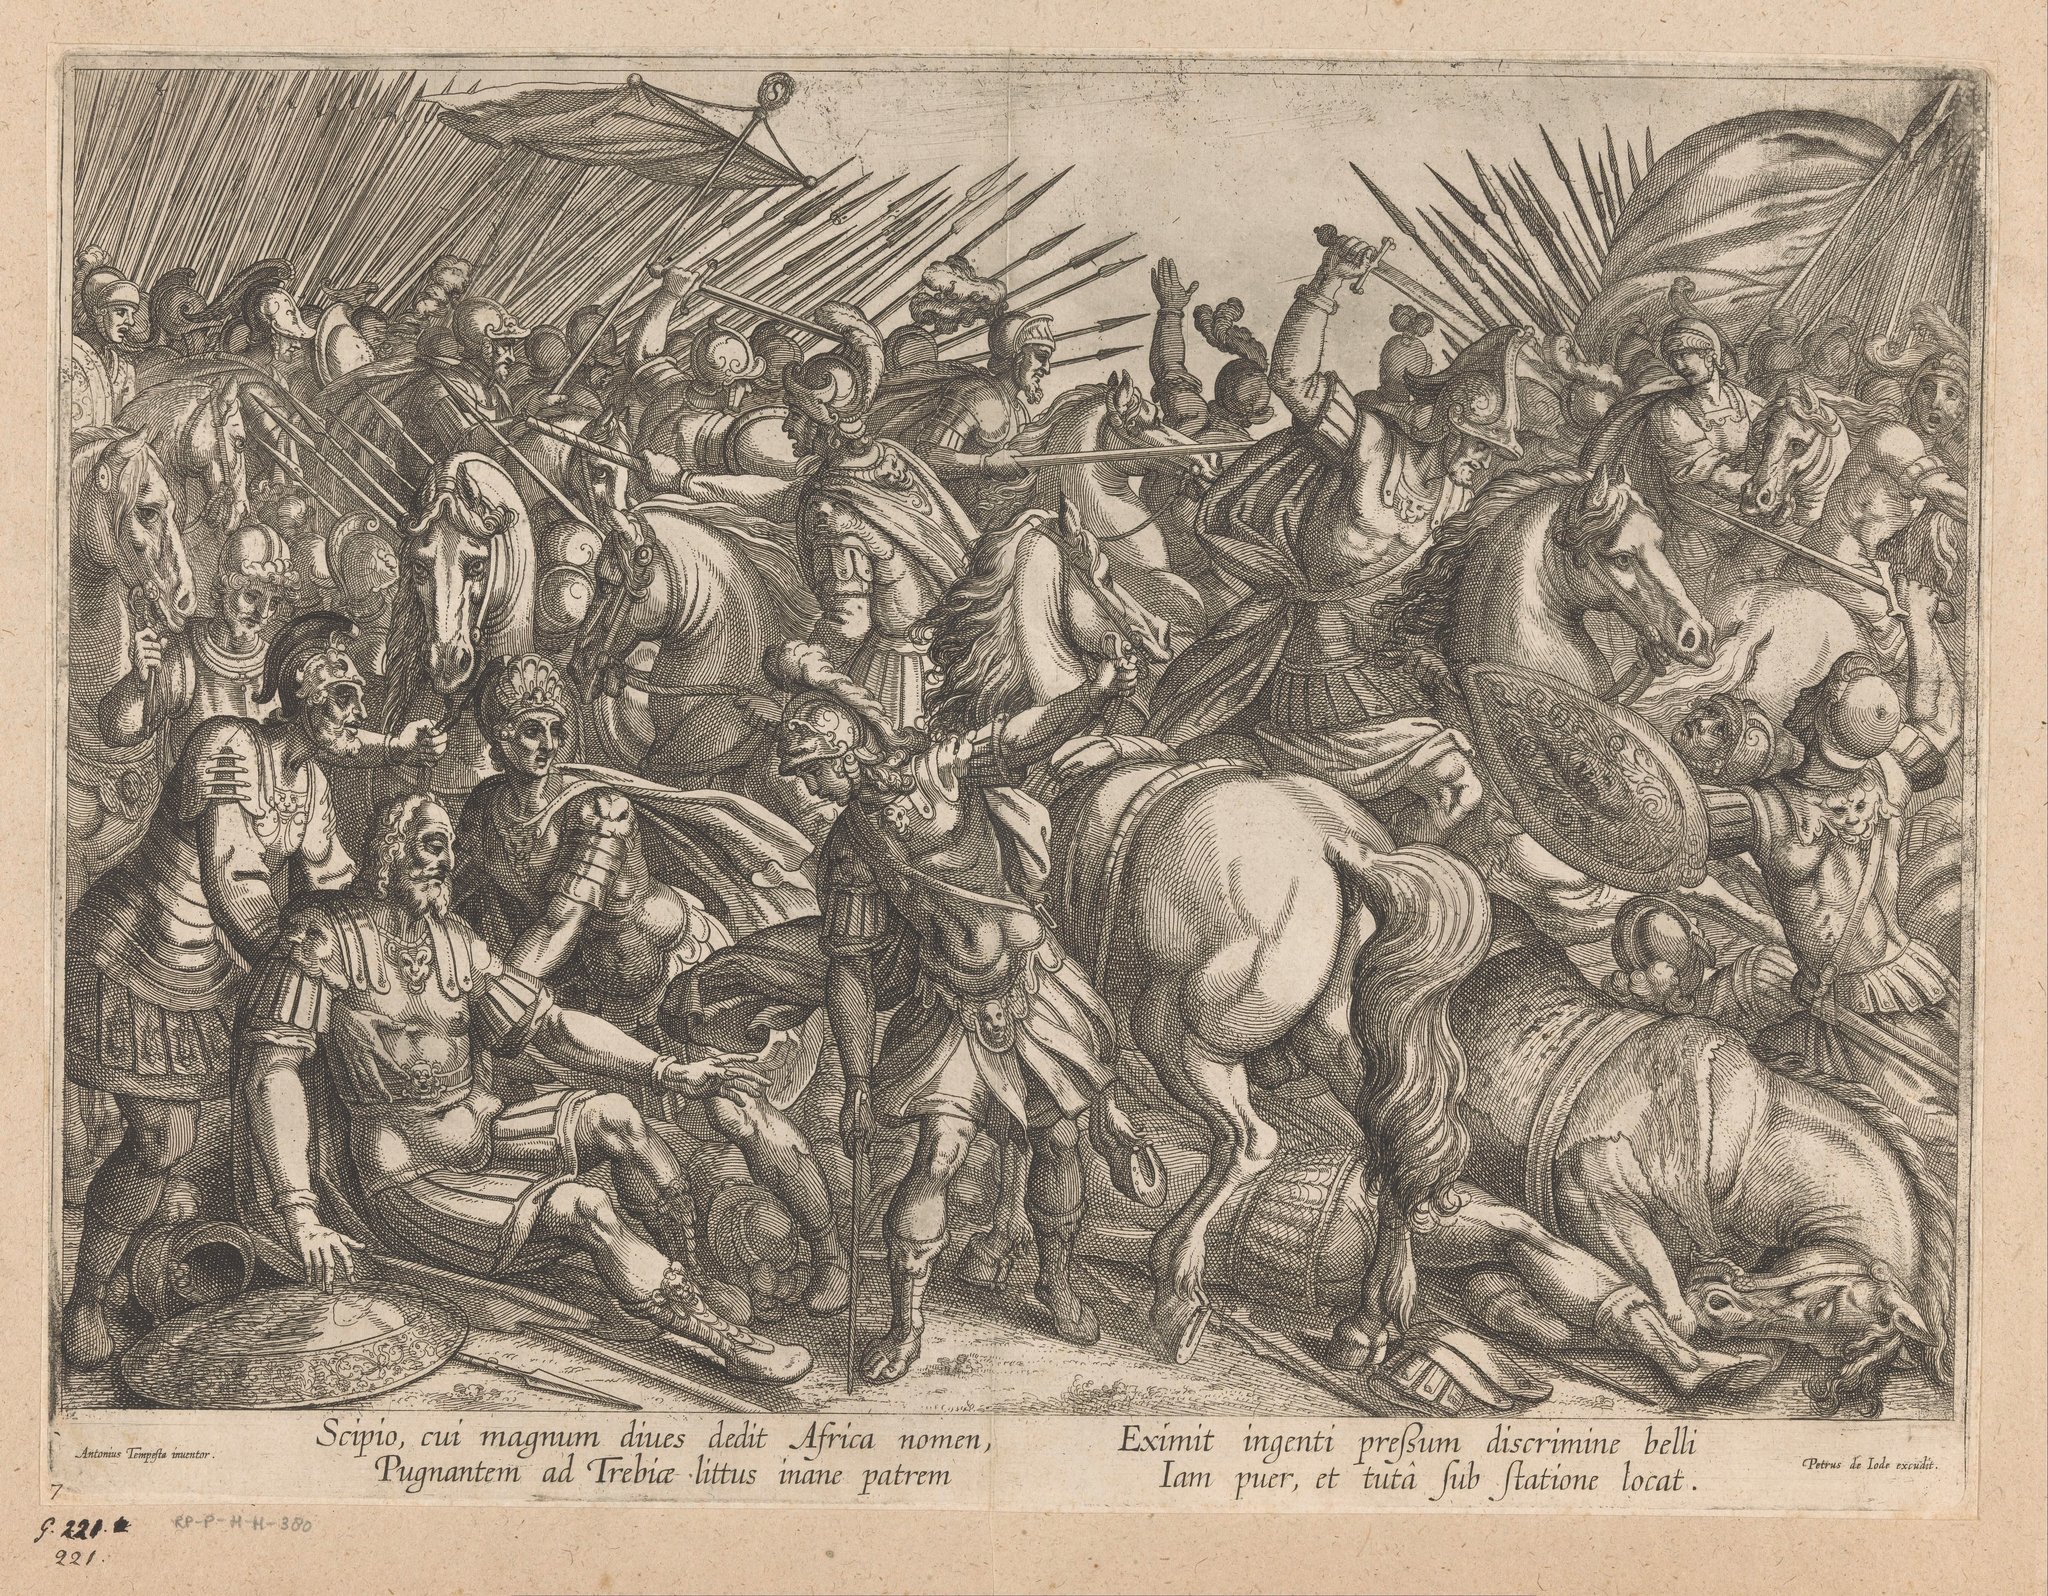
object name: print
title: Scipio Africanus en zijn strijdende leger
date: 1620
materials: paper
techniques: etching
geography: italy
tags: battle, (story of) p. cornelius scipio africanus major, the soldier; the soldier's life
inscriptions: collector's mark: ‘Hinloopen’, collector's mark: Lugt 11, number: ‘7’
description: Scipio Africanus en zijn strijdende leger. Op de voorgrond ligt een gewonde soldaat op de grond (Scipio?). Versregels in het Latijn in ondermarge.